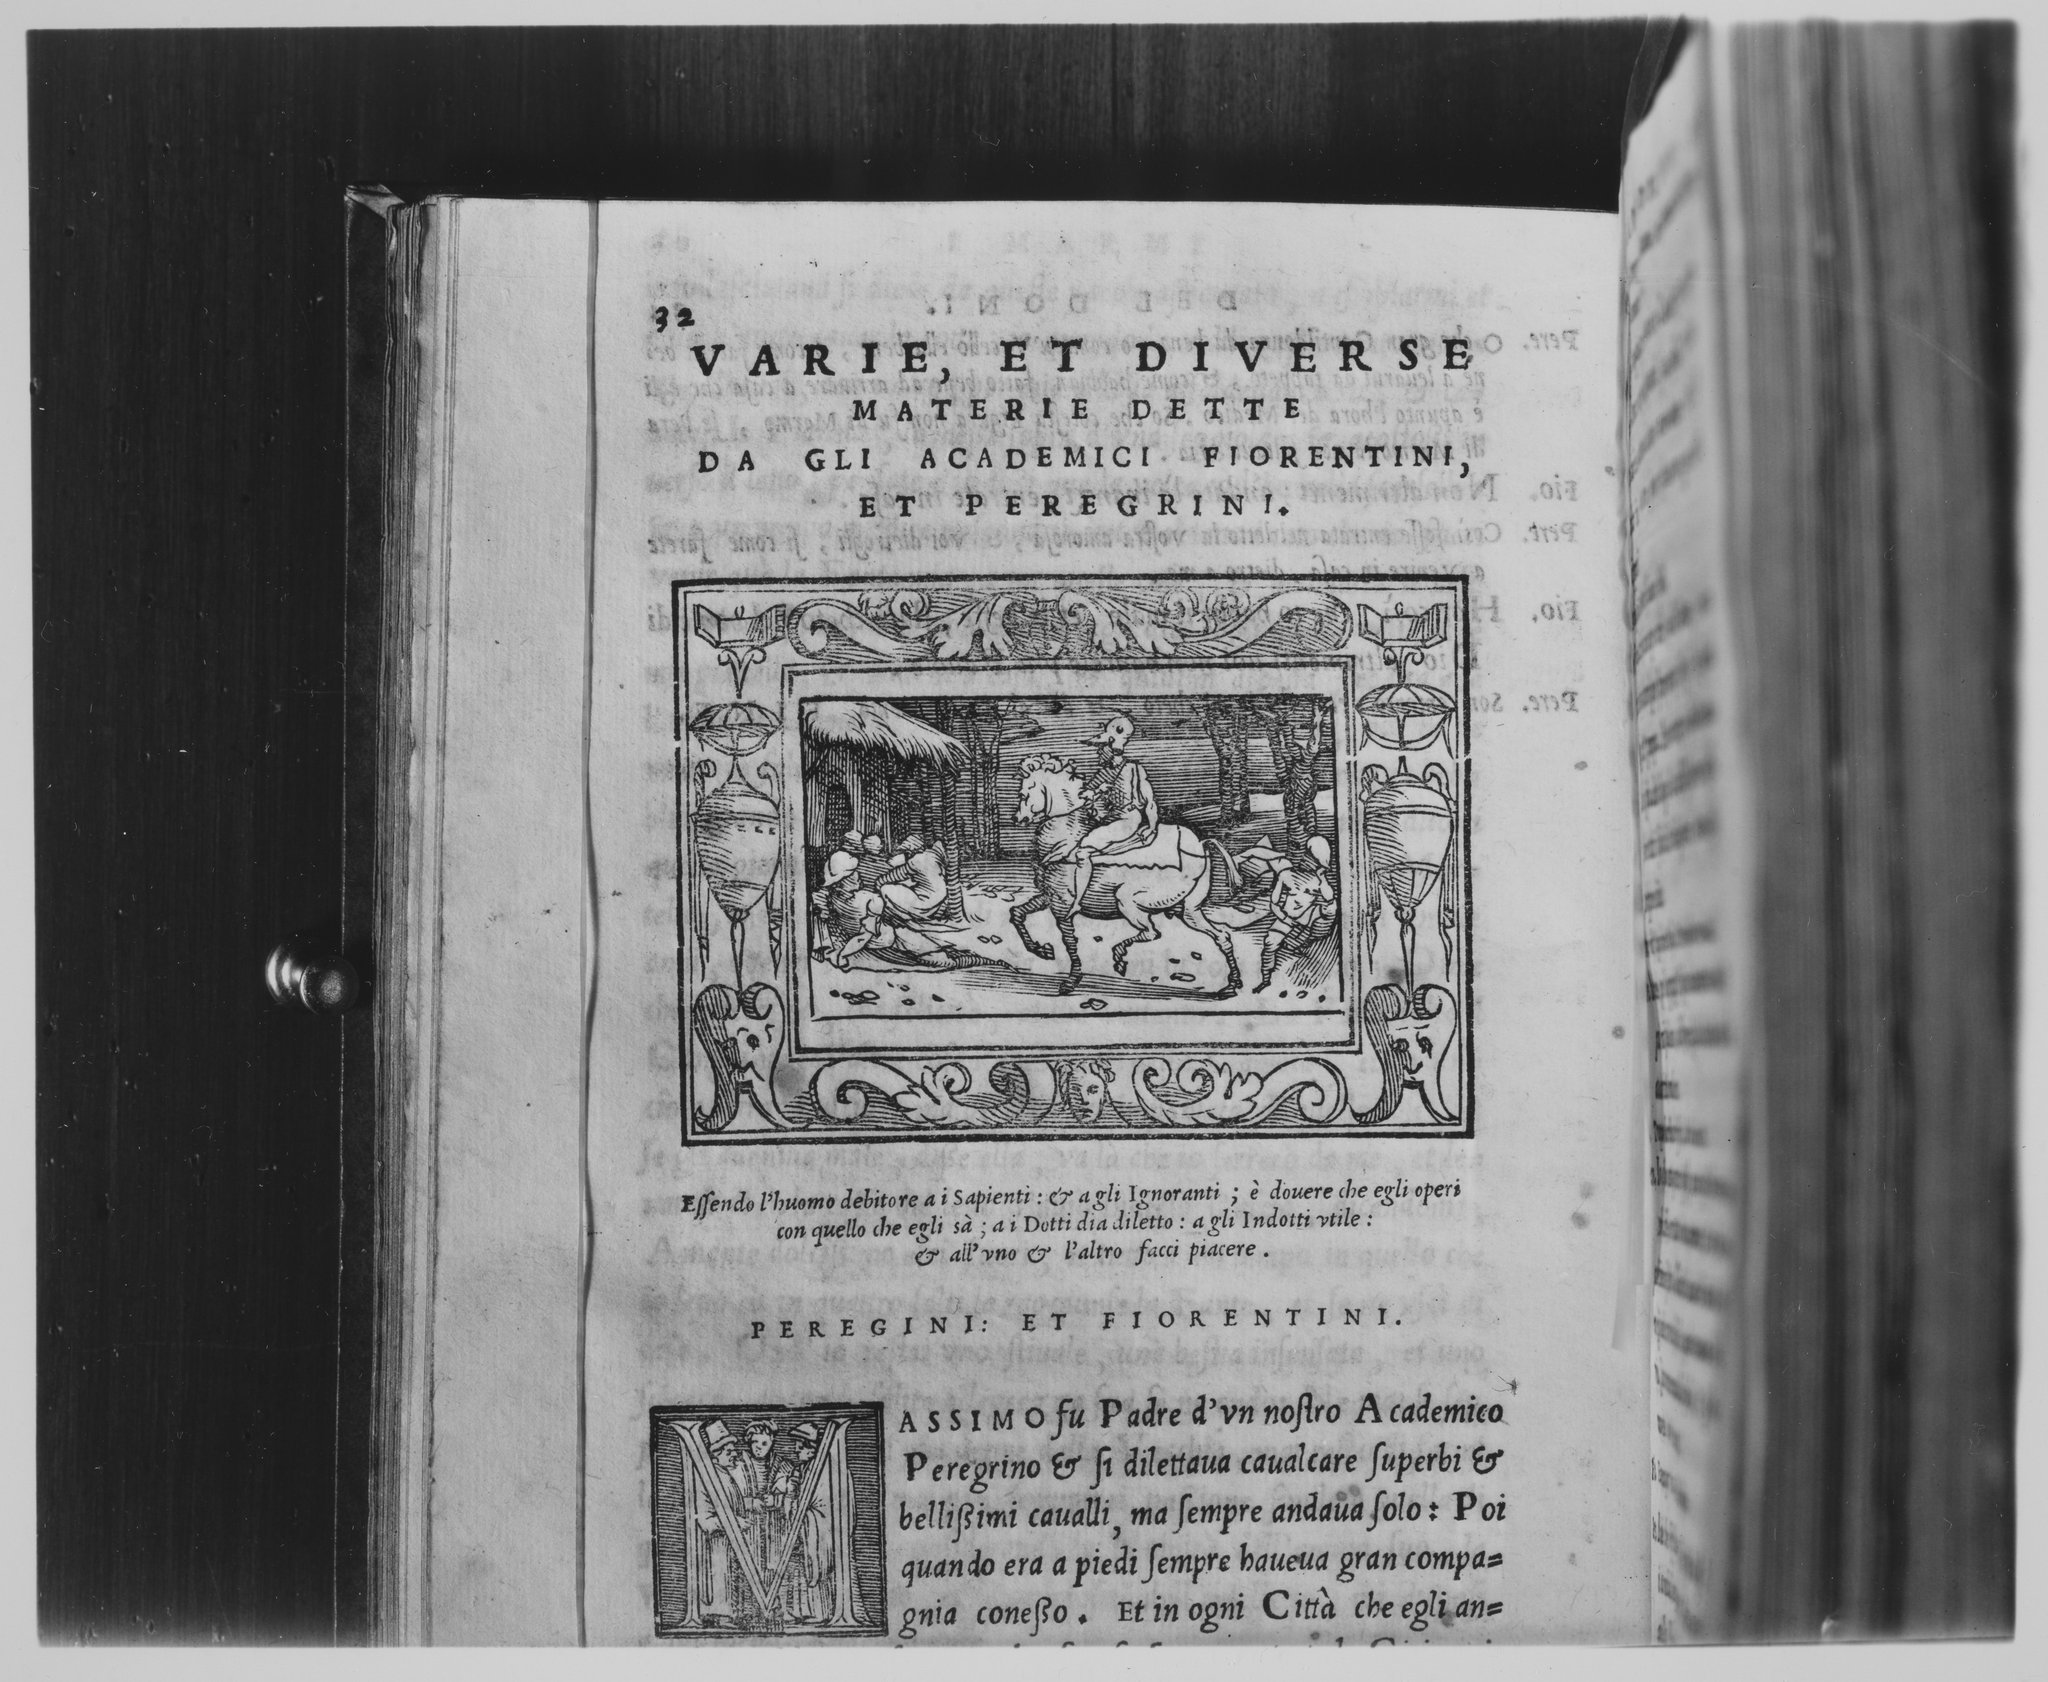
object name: book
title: I Marmi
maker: antonio francesco doni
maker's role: author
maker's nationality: italian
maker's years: 1513-1574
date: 1552-1553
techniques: printing, woodcut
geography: italy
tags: human figures,houses,horses